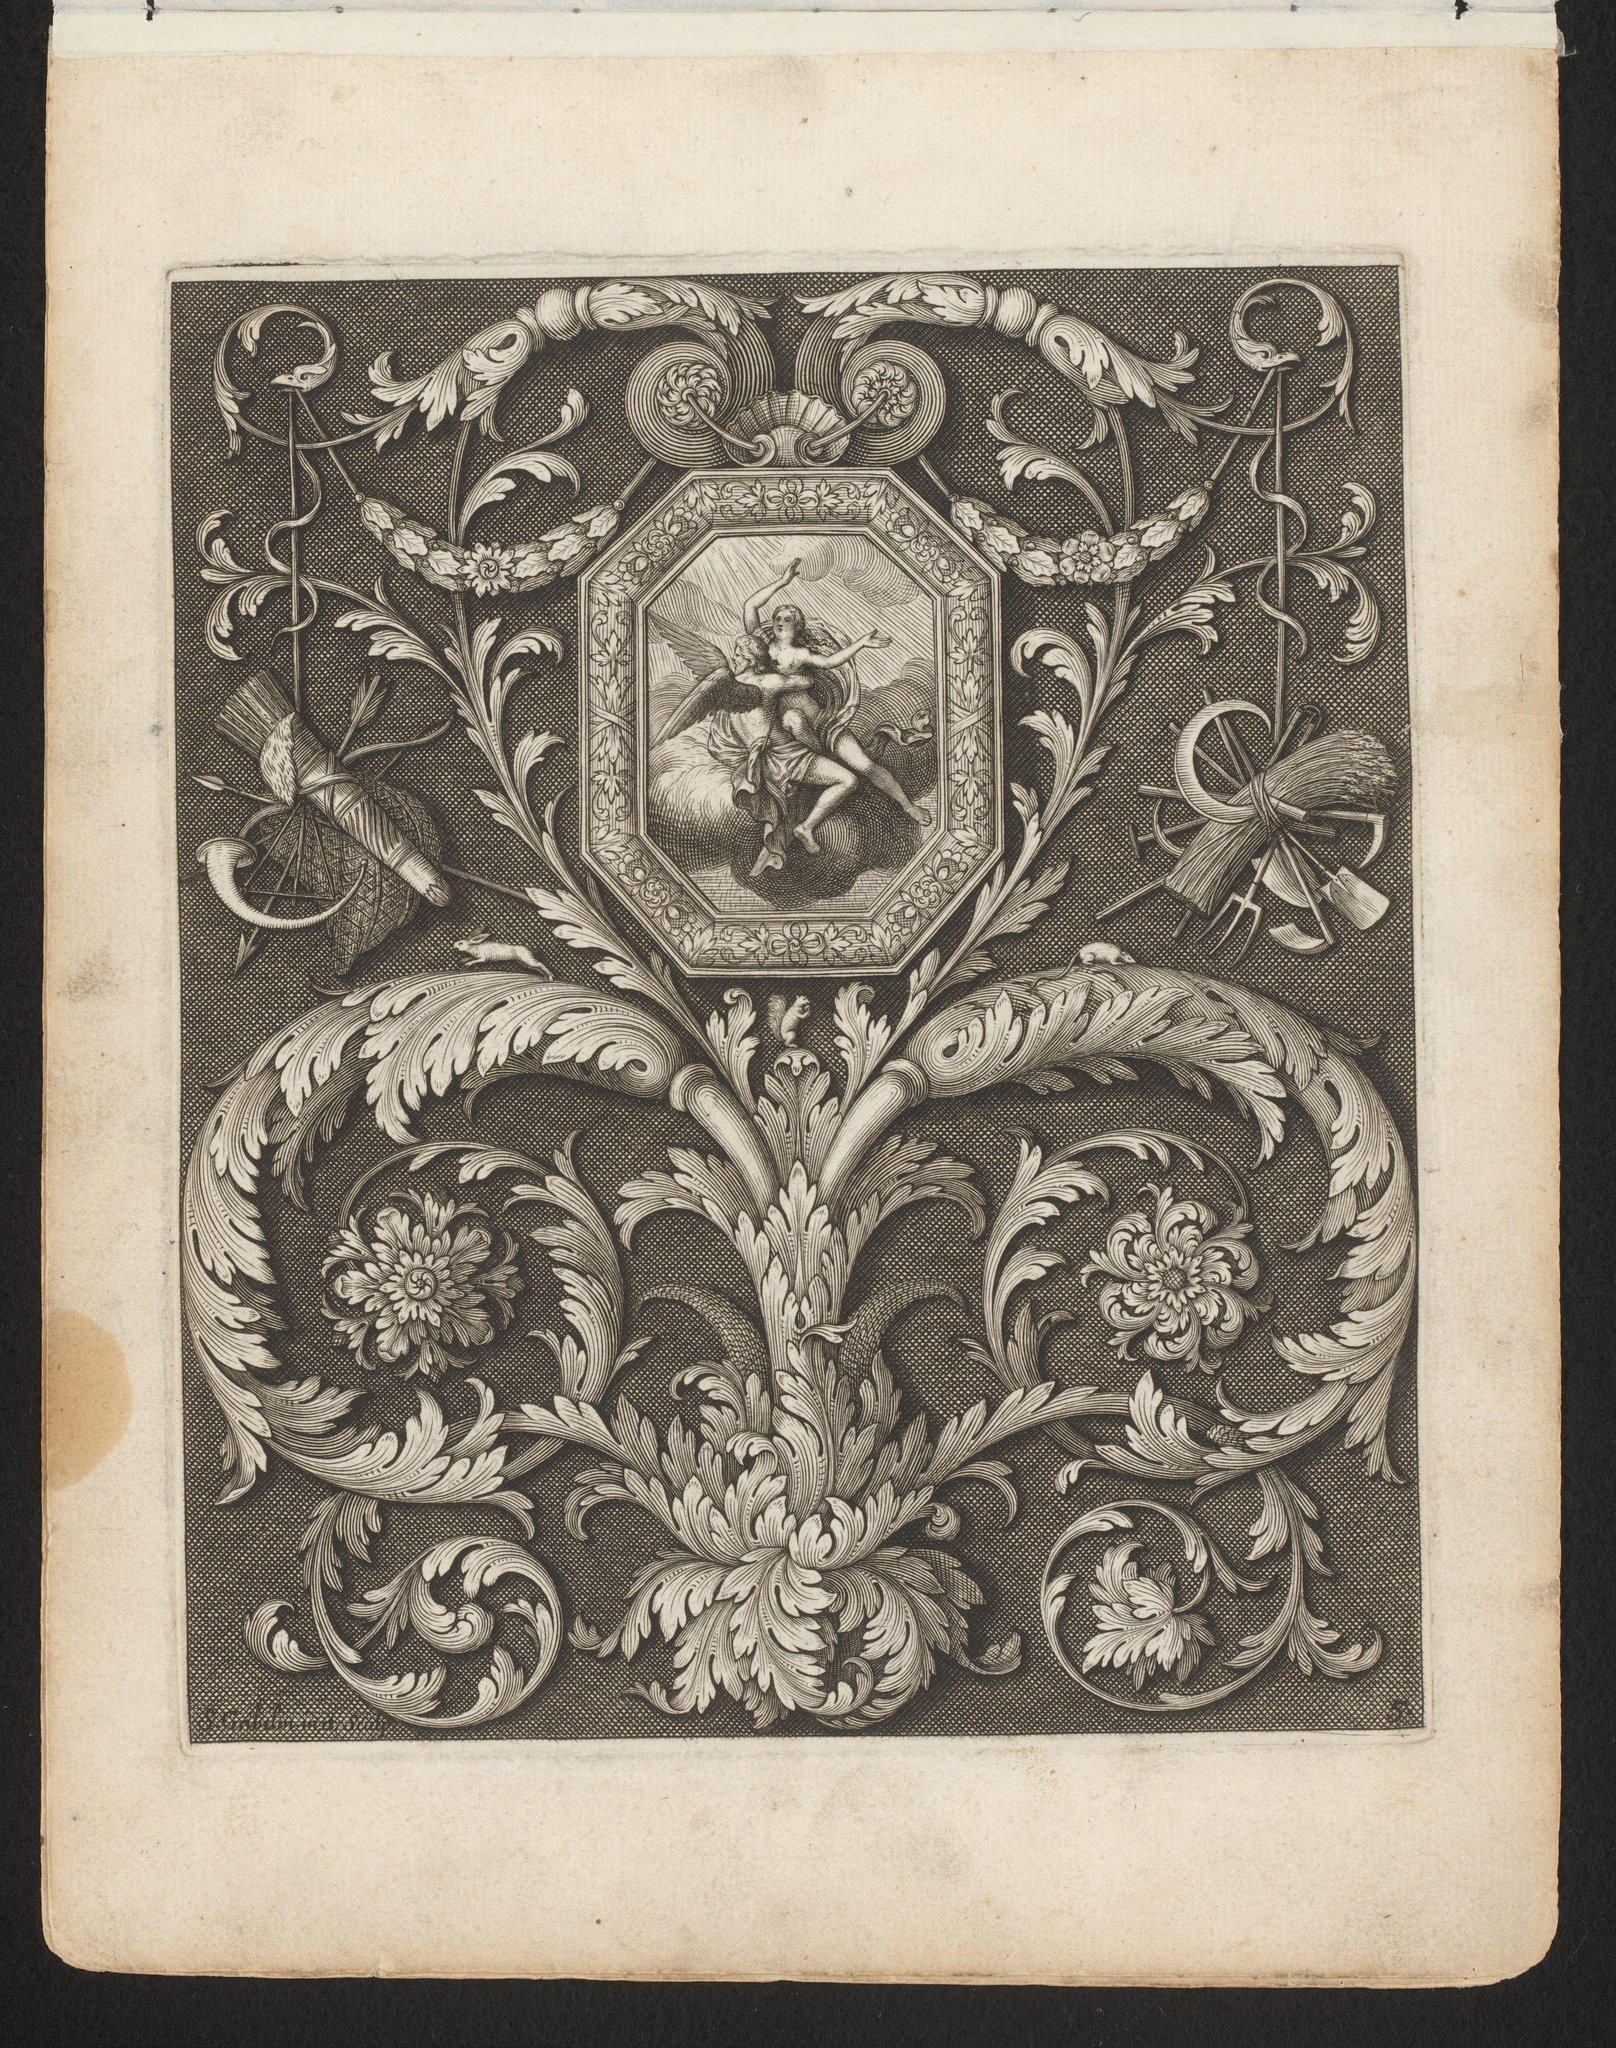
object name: ornament print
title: A Book of Ornaments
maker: simon gribelin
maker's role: print maker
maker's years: 1661-1733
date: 1704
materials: paper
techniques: engraving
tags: ornaments ~ art, 'tropaion', i.e. decorative ornament ~ weapons, cupids: 'amores', 'amoretti', 'putti', ornament derived from plant forms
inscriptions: collector's mark: Lugt 2760, collector's mark: Lugt 2228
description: De eerste versie van deze prentserie is uitgegeven in 1682 met de titel 'A Book of Severall Ornaments'.